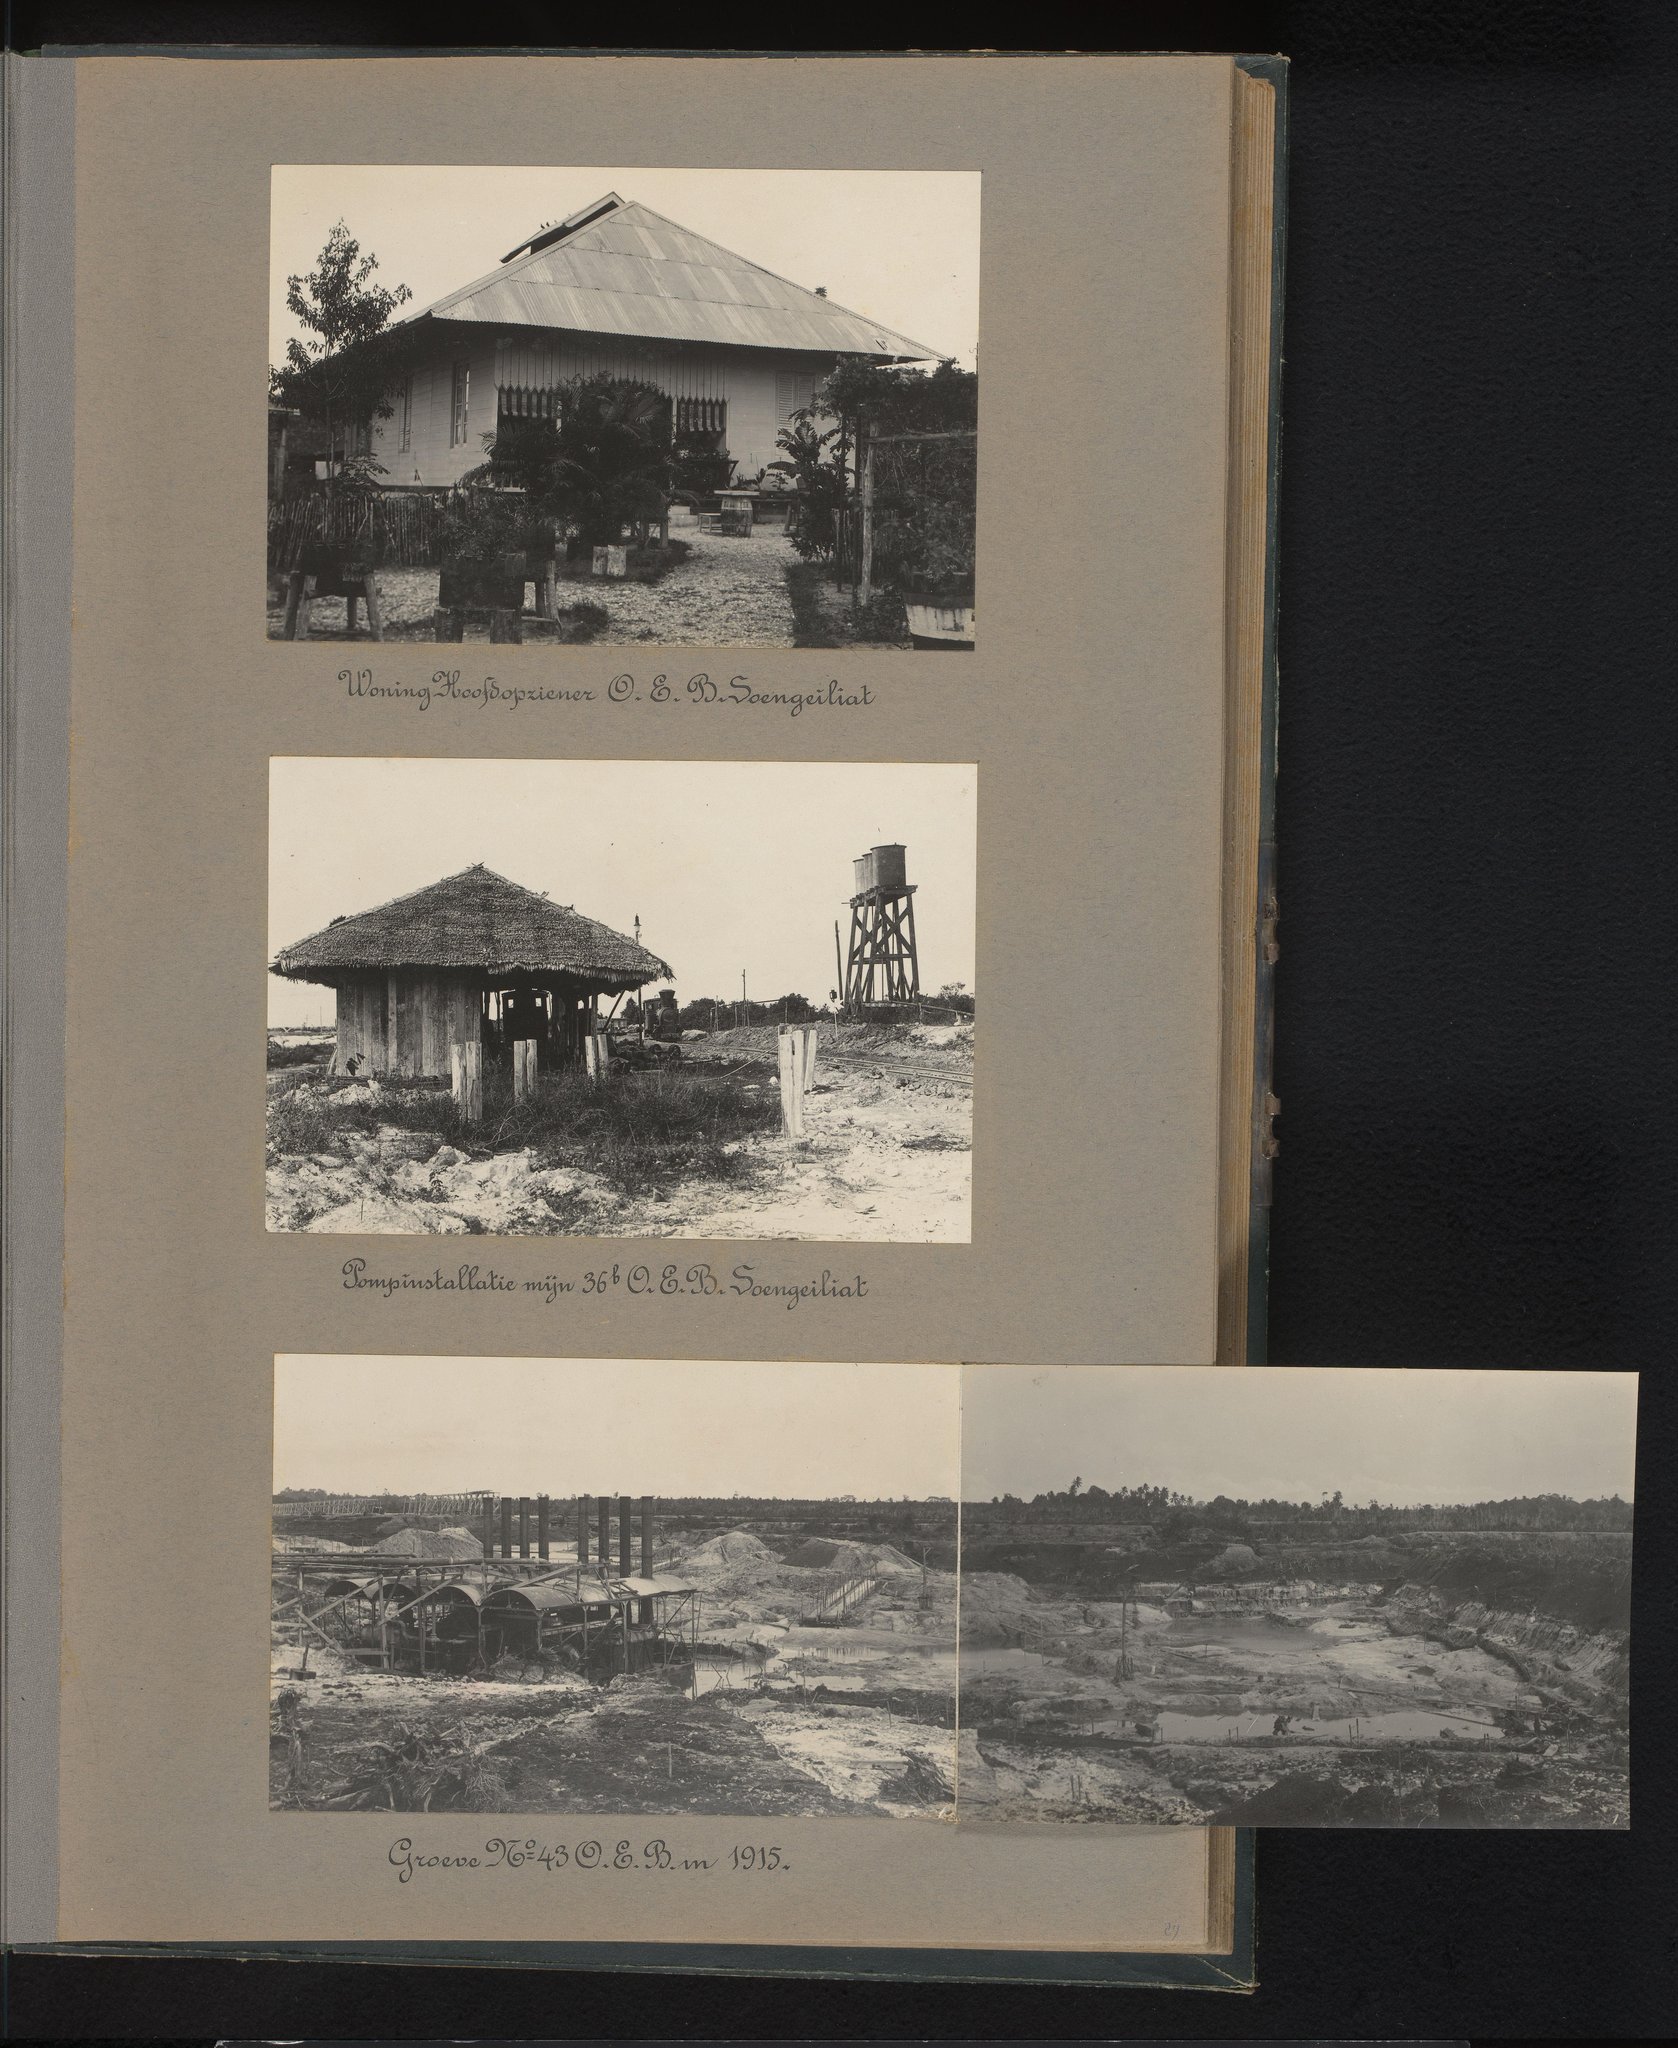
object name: photograph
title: Woning, pompinstallatie en panorama van een mijn van de Banka-tinwinning te Soengeiliat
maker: Anonymous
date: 1914-1919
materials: cardboard, photographic support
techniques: gelatin silver print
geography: bangka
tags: robert julius boers, colonial system, opencast mine; strip mining, rural housing, e.g. country-house, villa, cottage, exterior of industrial structures, factories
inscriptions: inscription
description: Albumblad met 3 foto's van een woning, pompinstallatie en een panorama van mijn 43 van de Banka-tinwinning te Soengeiliat. Onderdeel van het fotoalbum aangeboden aan Robert Julius Boers bij zijn vertrek naar Nederland in 1919 door het personeel van de Banka-tinwinning.